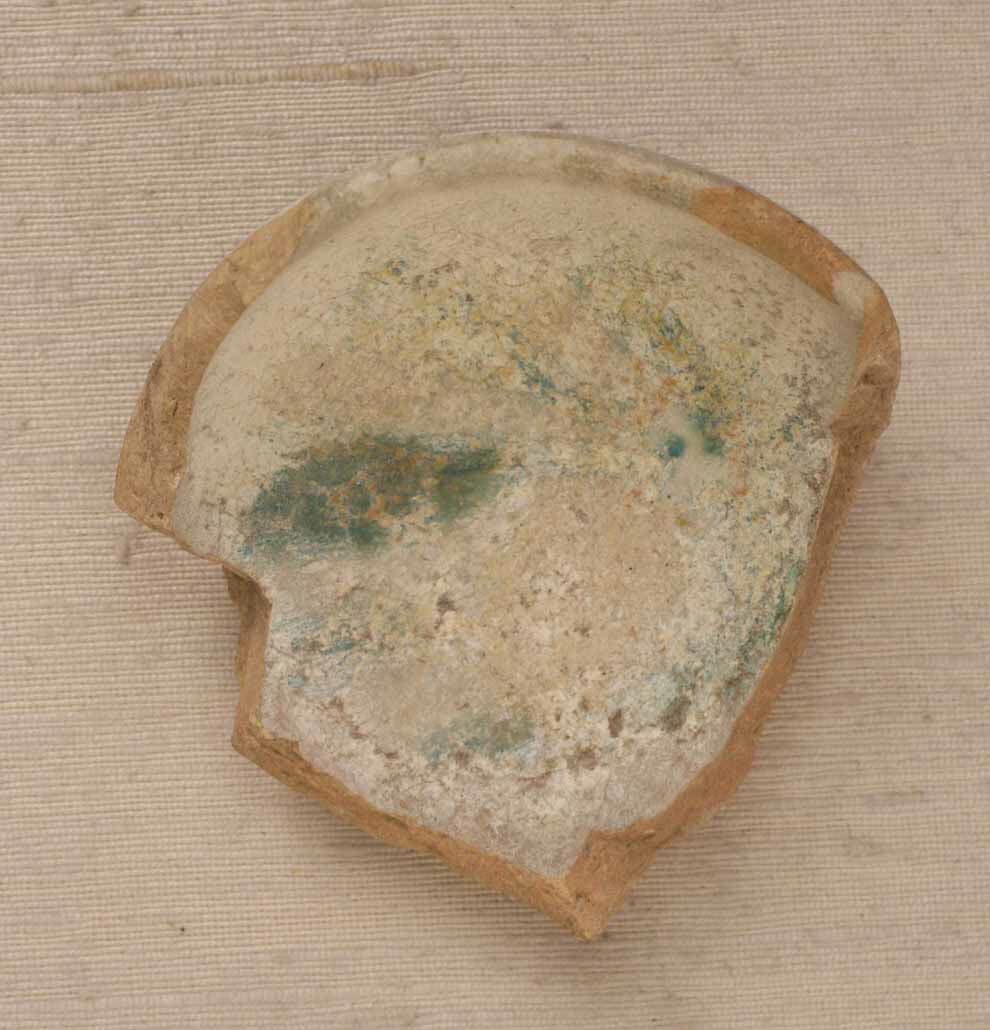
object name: fragment of a bowl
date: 701-900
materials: earthenware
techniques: glazing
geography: iraq